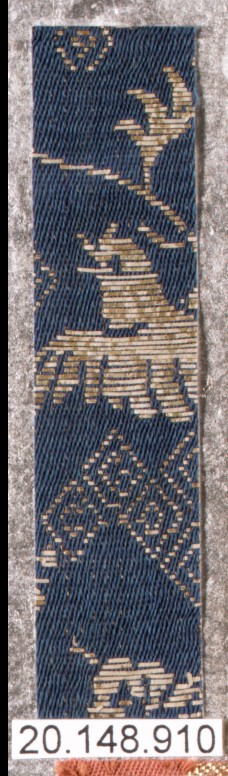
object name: piece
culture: japanese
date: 1601-1700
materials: silk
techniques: compound weave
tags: birds